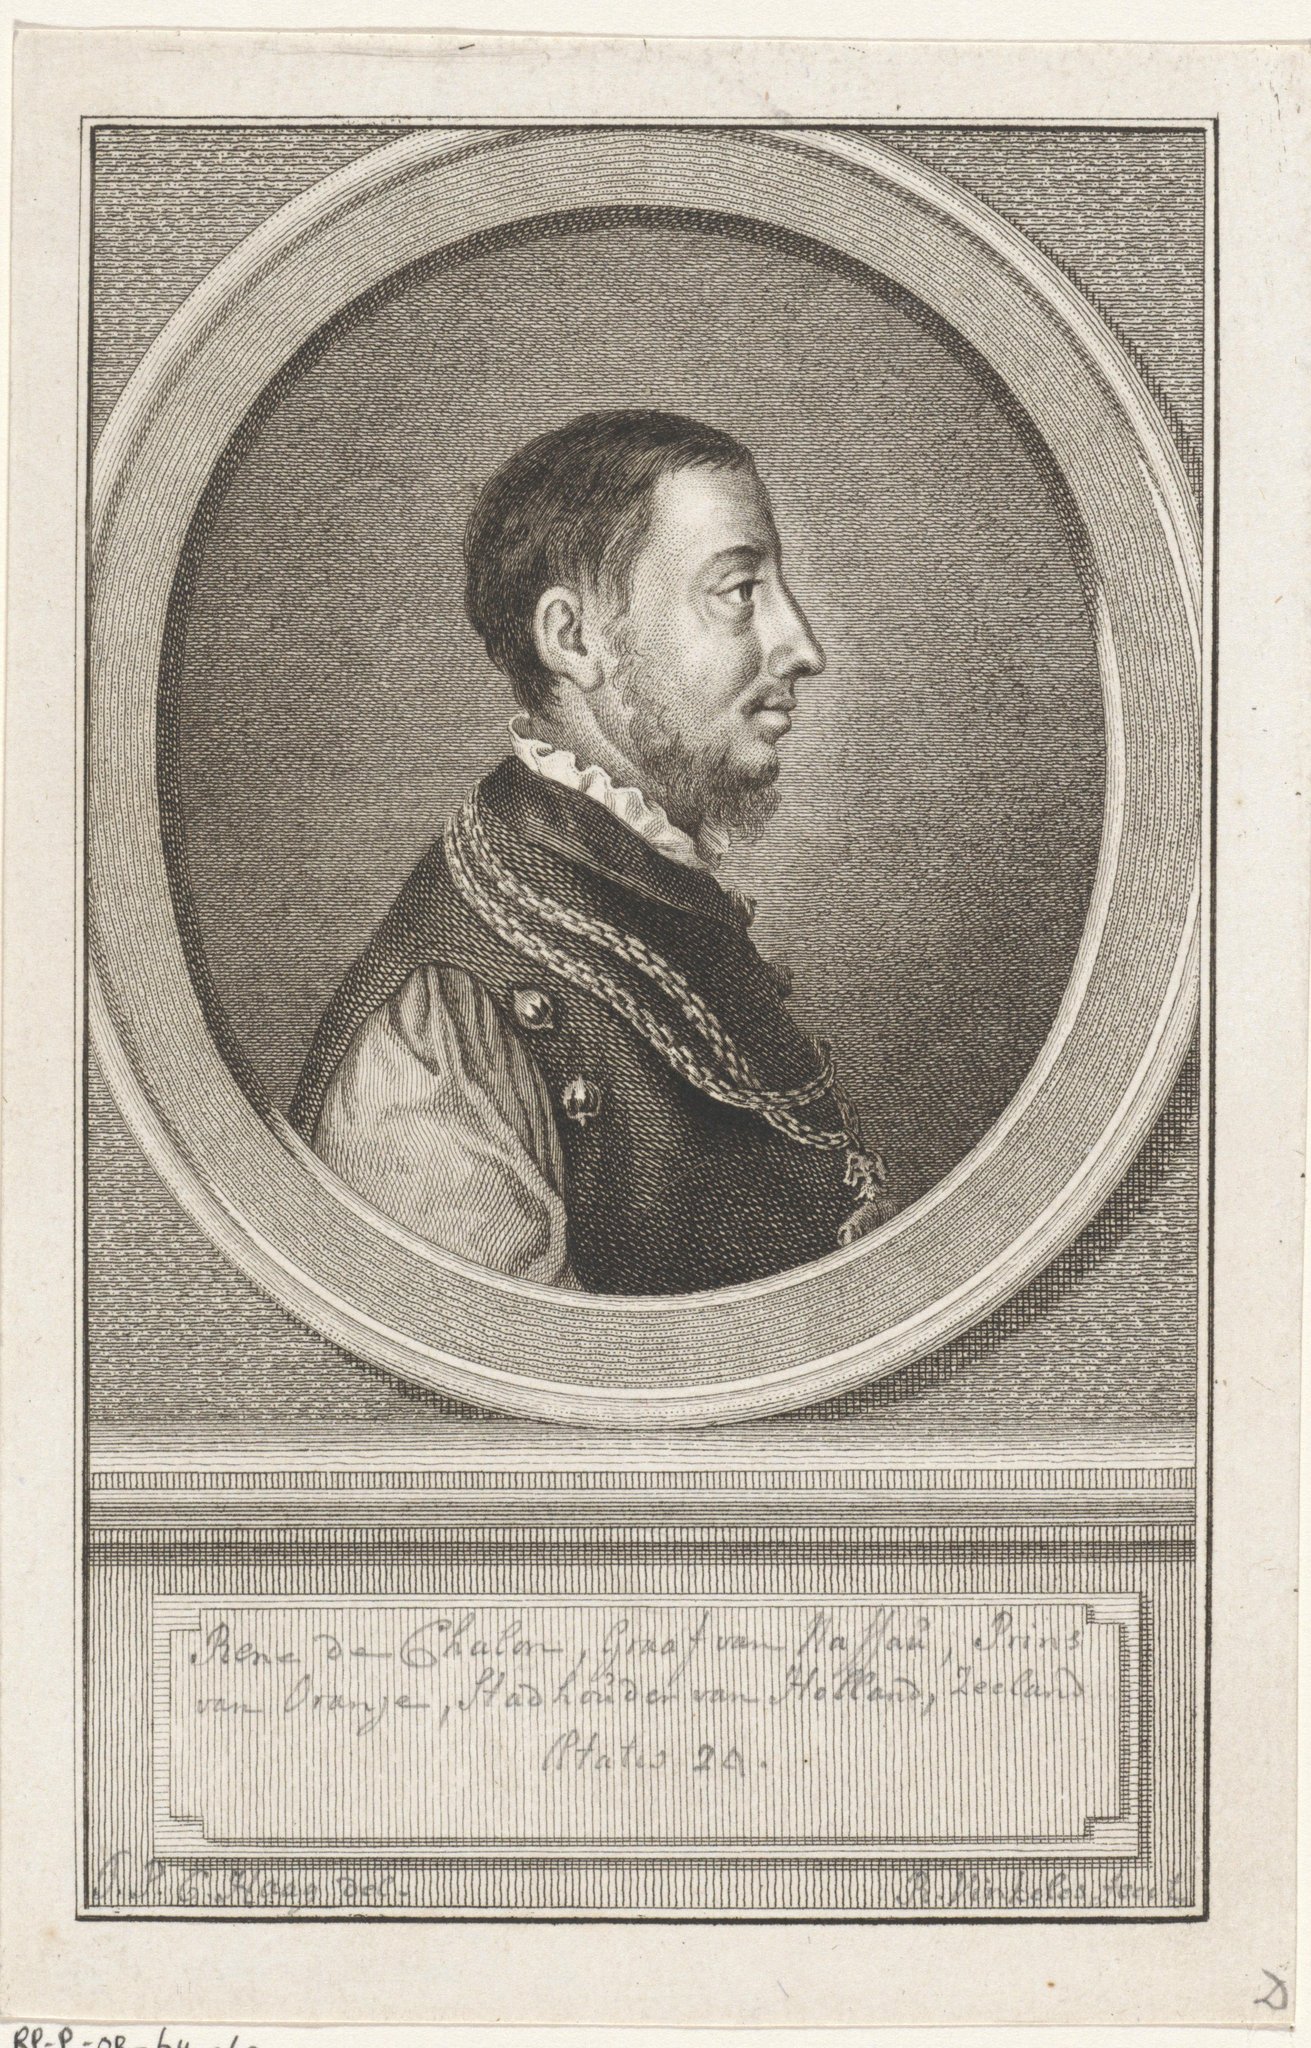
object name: print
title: Portret van René van Châlon, prins van Oranje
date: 1758-1816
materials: paper, pencil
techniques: engraving, etching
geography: amsterdam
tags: stadhouder, rené van châlon (prins van oranje)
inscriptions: collector's mark: Lugt 240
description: Portret van René van Châlon, prins van Oranje, stadhouder van Holland en Zeeland.